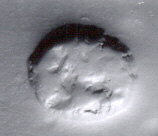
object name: stamp seal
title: Stamp seal (scaraboid) with animal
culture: assyrian or phoenician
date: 900-601 BCE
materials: stone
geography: levant or syria